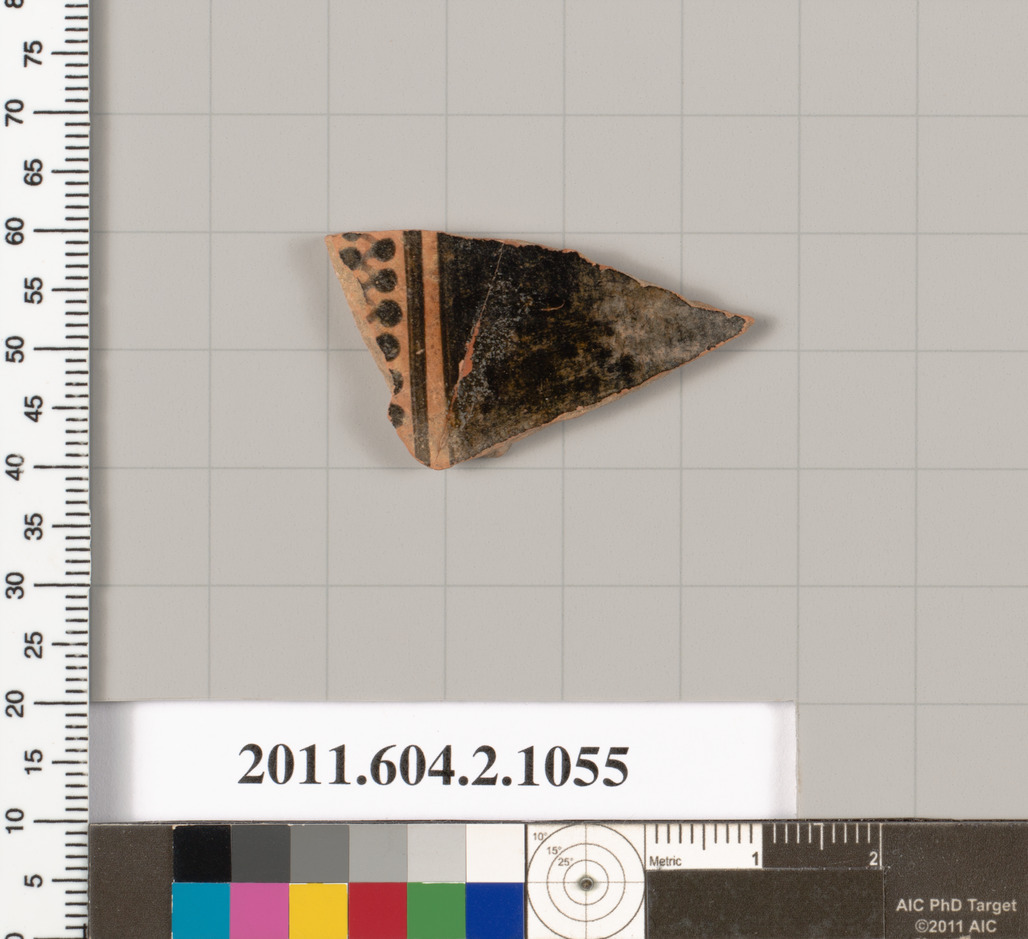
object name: pelike fragment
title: Terracotta fragment of a pelike (jar)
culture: greek, attic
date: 475-451 BCE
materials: terracotta